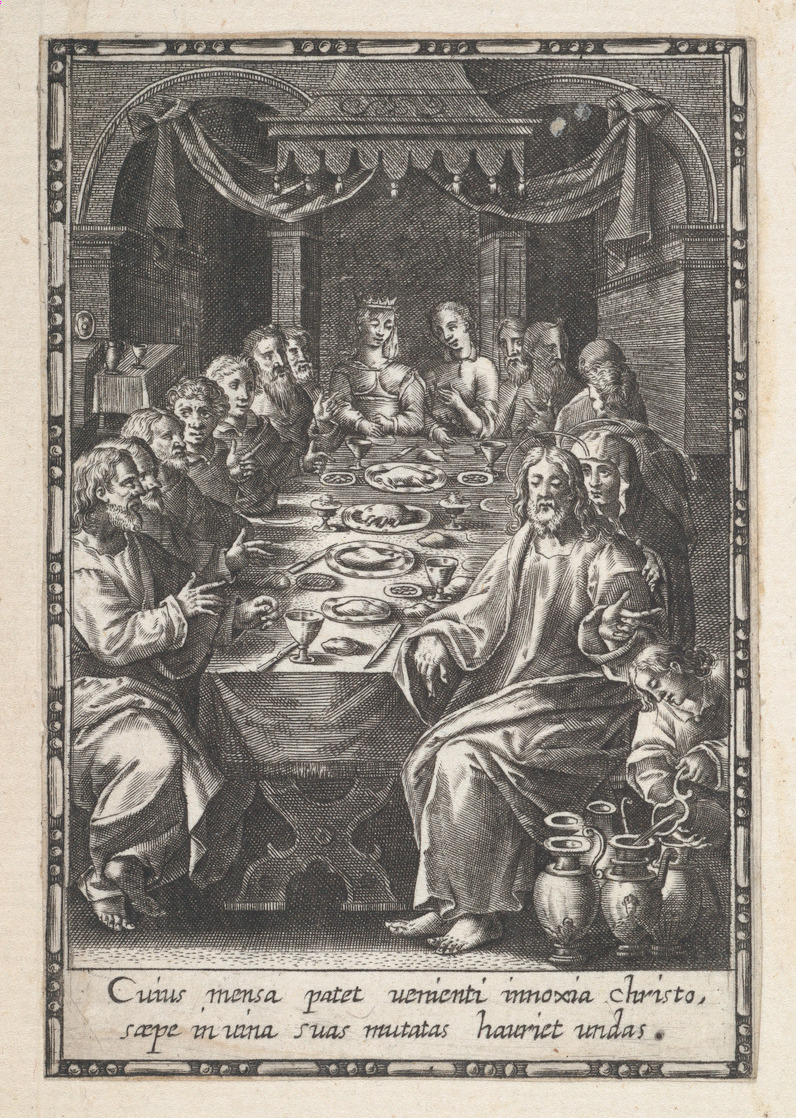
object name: print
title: The Marriage at Cana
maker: Anonymous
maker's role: artist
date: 1590-1620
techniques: engraving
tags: food,men,women,christ,dining